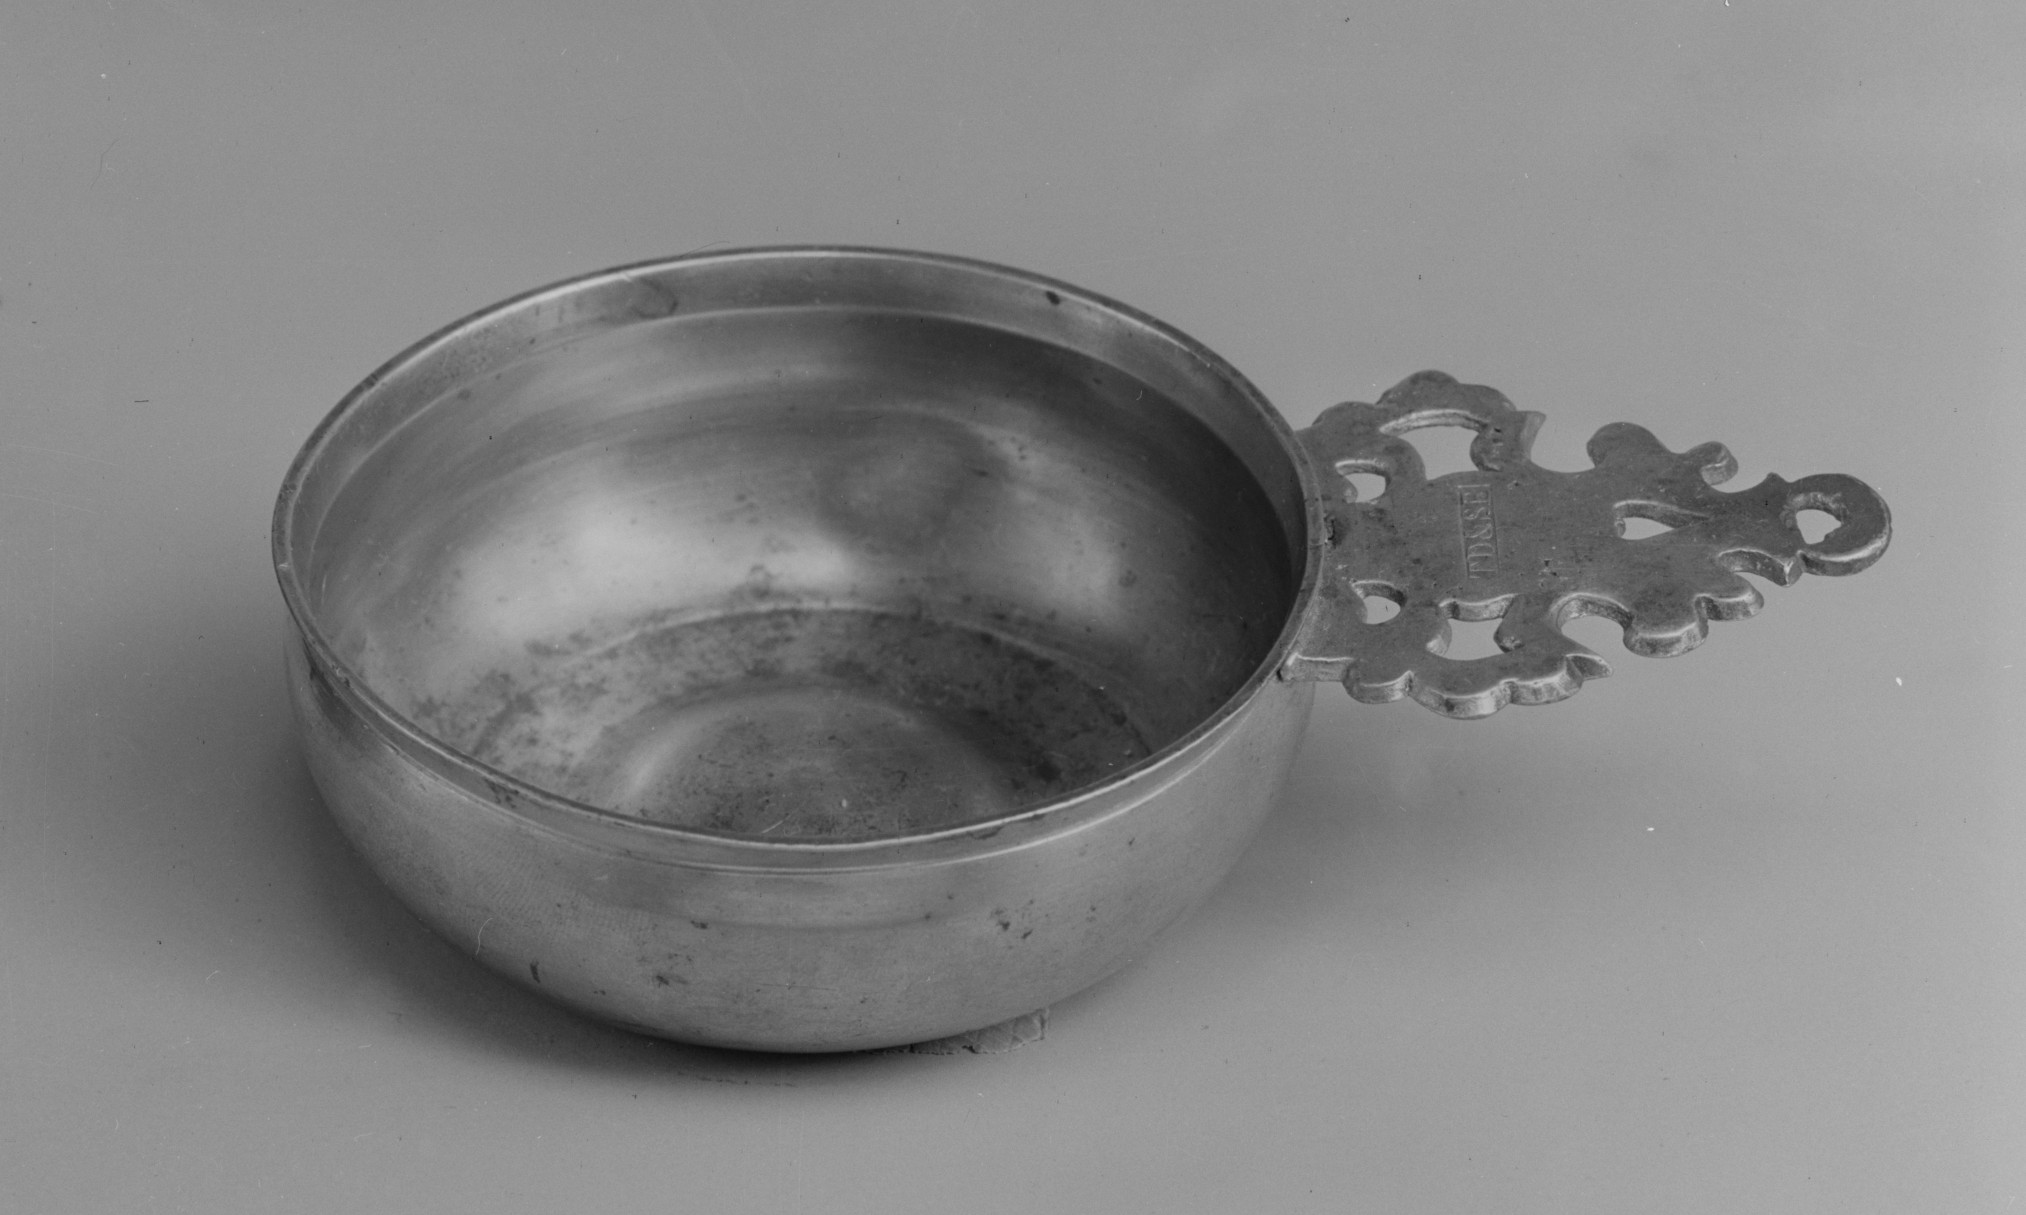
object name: porringer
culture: american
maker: thomas danforth boardman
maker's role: maker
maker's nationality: american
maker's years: 1784-1873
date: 1810-1850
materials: pewter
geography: united states